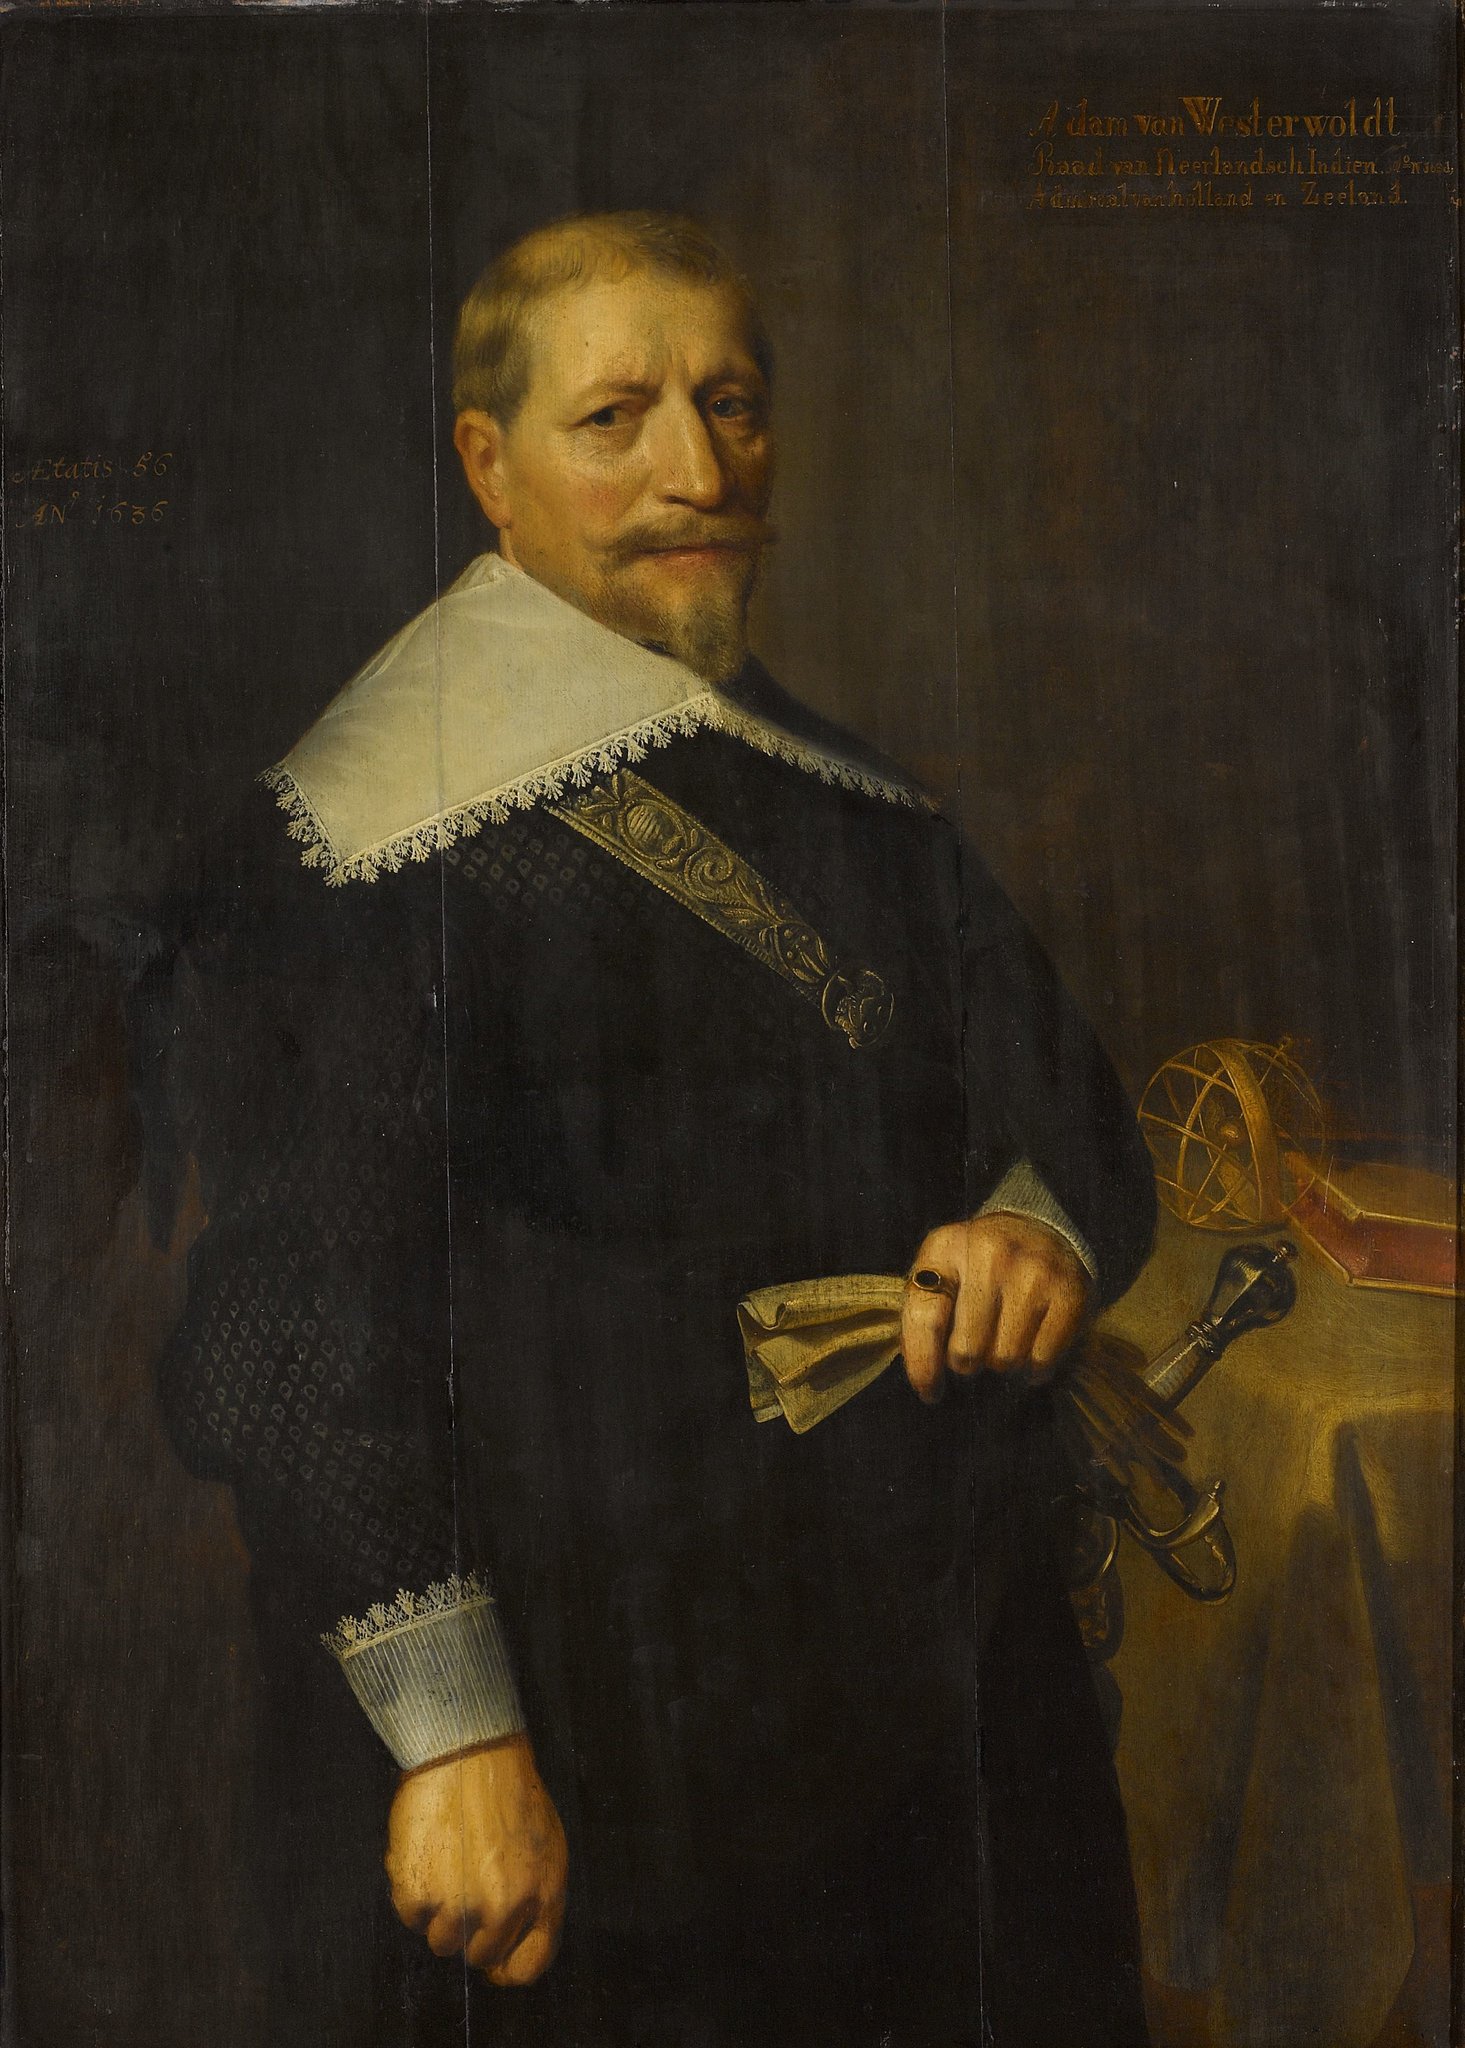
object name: painting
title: Portrait of Adam Westerwolt, Extra-ordinary Councilor of the Dutch East India Company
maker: Anonymous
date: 1636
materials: oil, panel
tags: delft, historical persons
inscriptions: inscription and date, left: ‘Ætatis 56/Ano 1636’, inscription, upper right: ‘Adam van Westerwoldt, Raad van Nederlandsch Indien Anº 1638 admiraal van Holland en Zeeland.’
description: Adam van Westerwolt, by M.J. van Miereveld, 1636. After a succession of posts in the VOC, Adam van Westerwolt (1580-1639) was appointed to the East Indies Council, an important position within the VOC in Asia. In 1637 he was sent as admiral of a VOC-fleet to blockade Portuguese trade in the Indian city of Goa. Van Westerwolt commissioned this portrait shortly before leaving for Asia. On the table is an astrolabe, a navigational instrument.